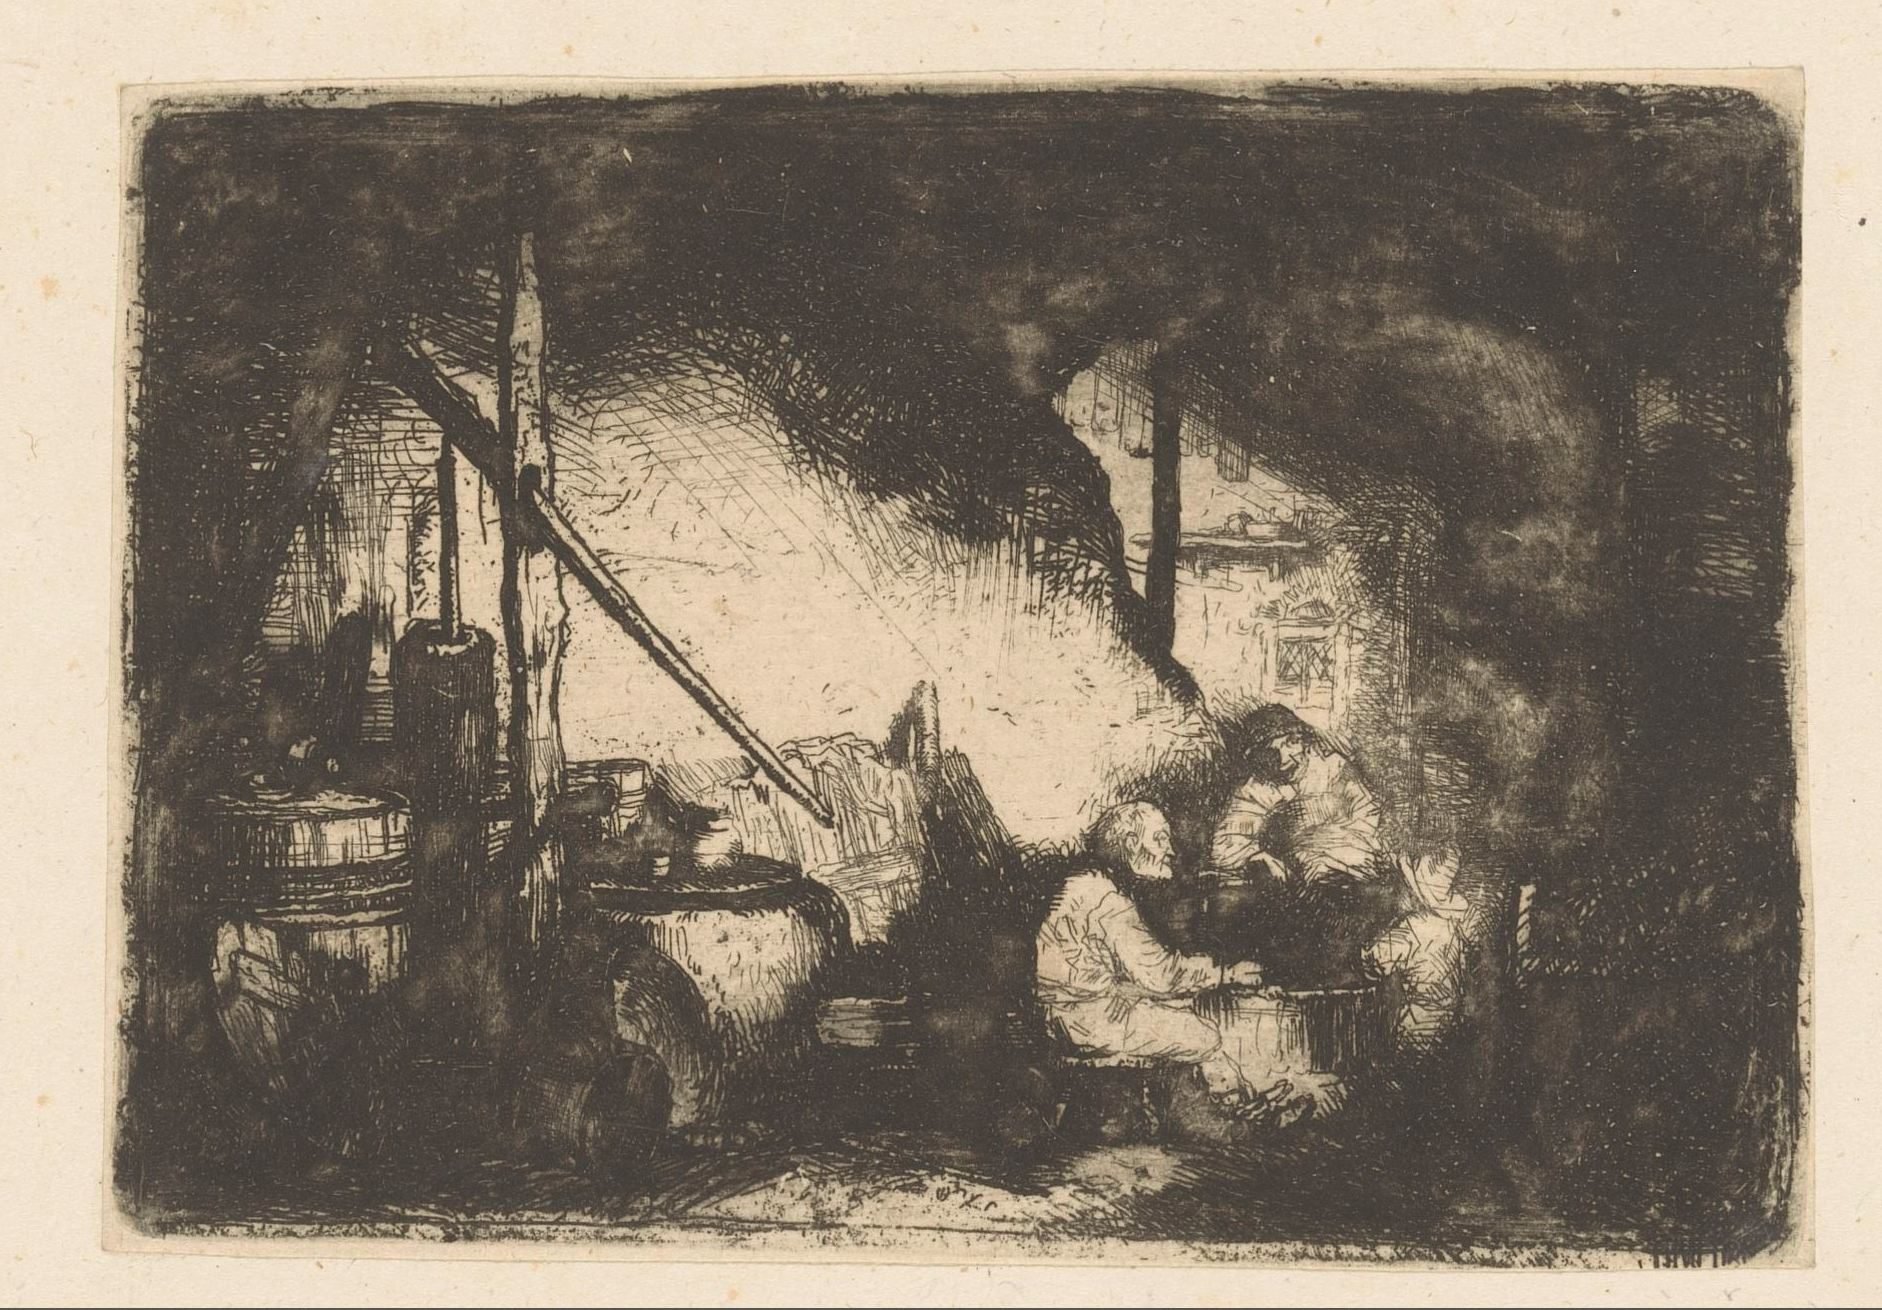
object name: print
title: Drie figuren aan tafel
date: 1722-1774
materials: paper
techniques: drypoint, etching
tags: city-view, and landscape with man-made constructions, family life, pump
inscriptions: collector's mark: Lugt 2760, collector's mark: Lugt 2228